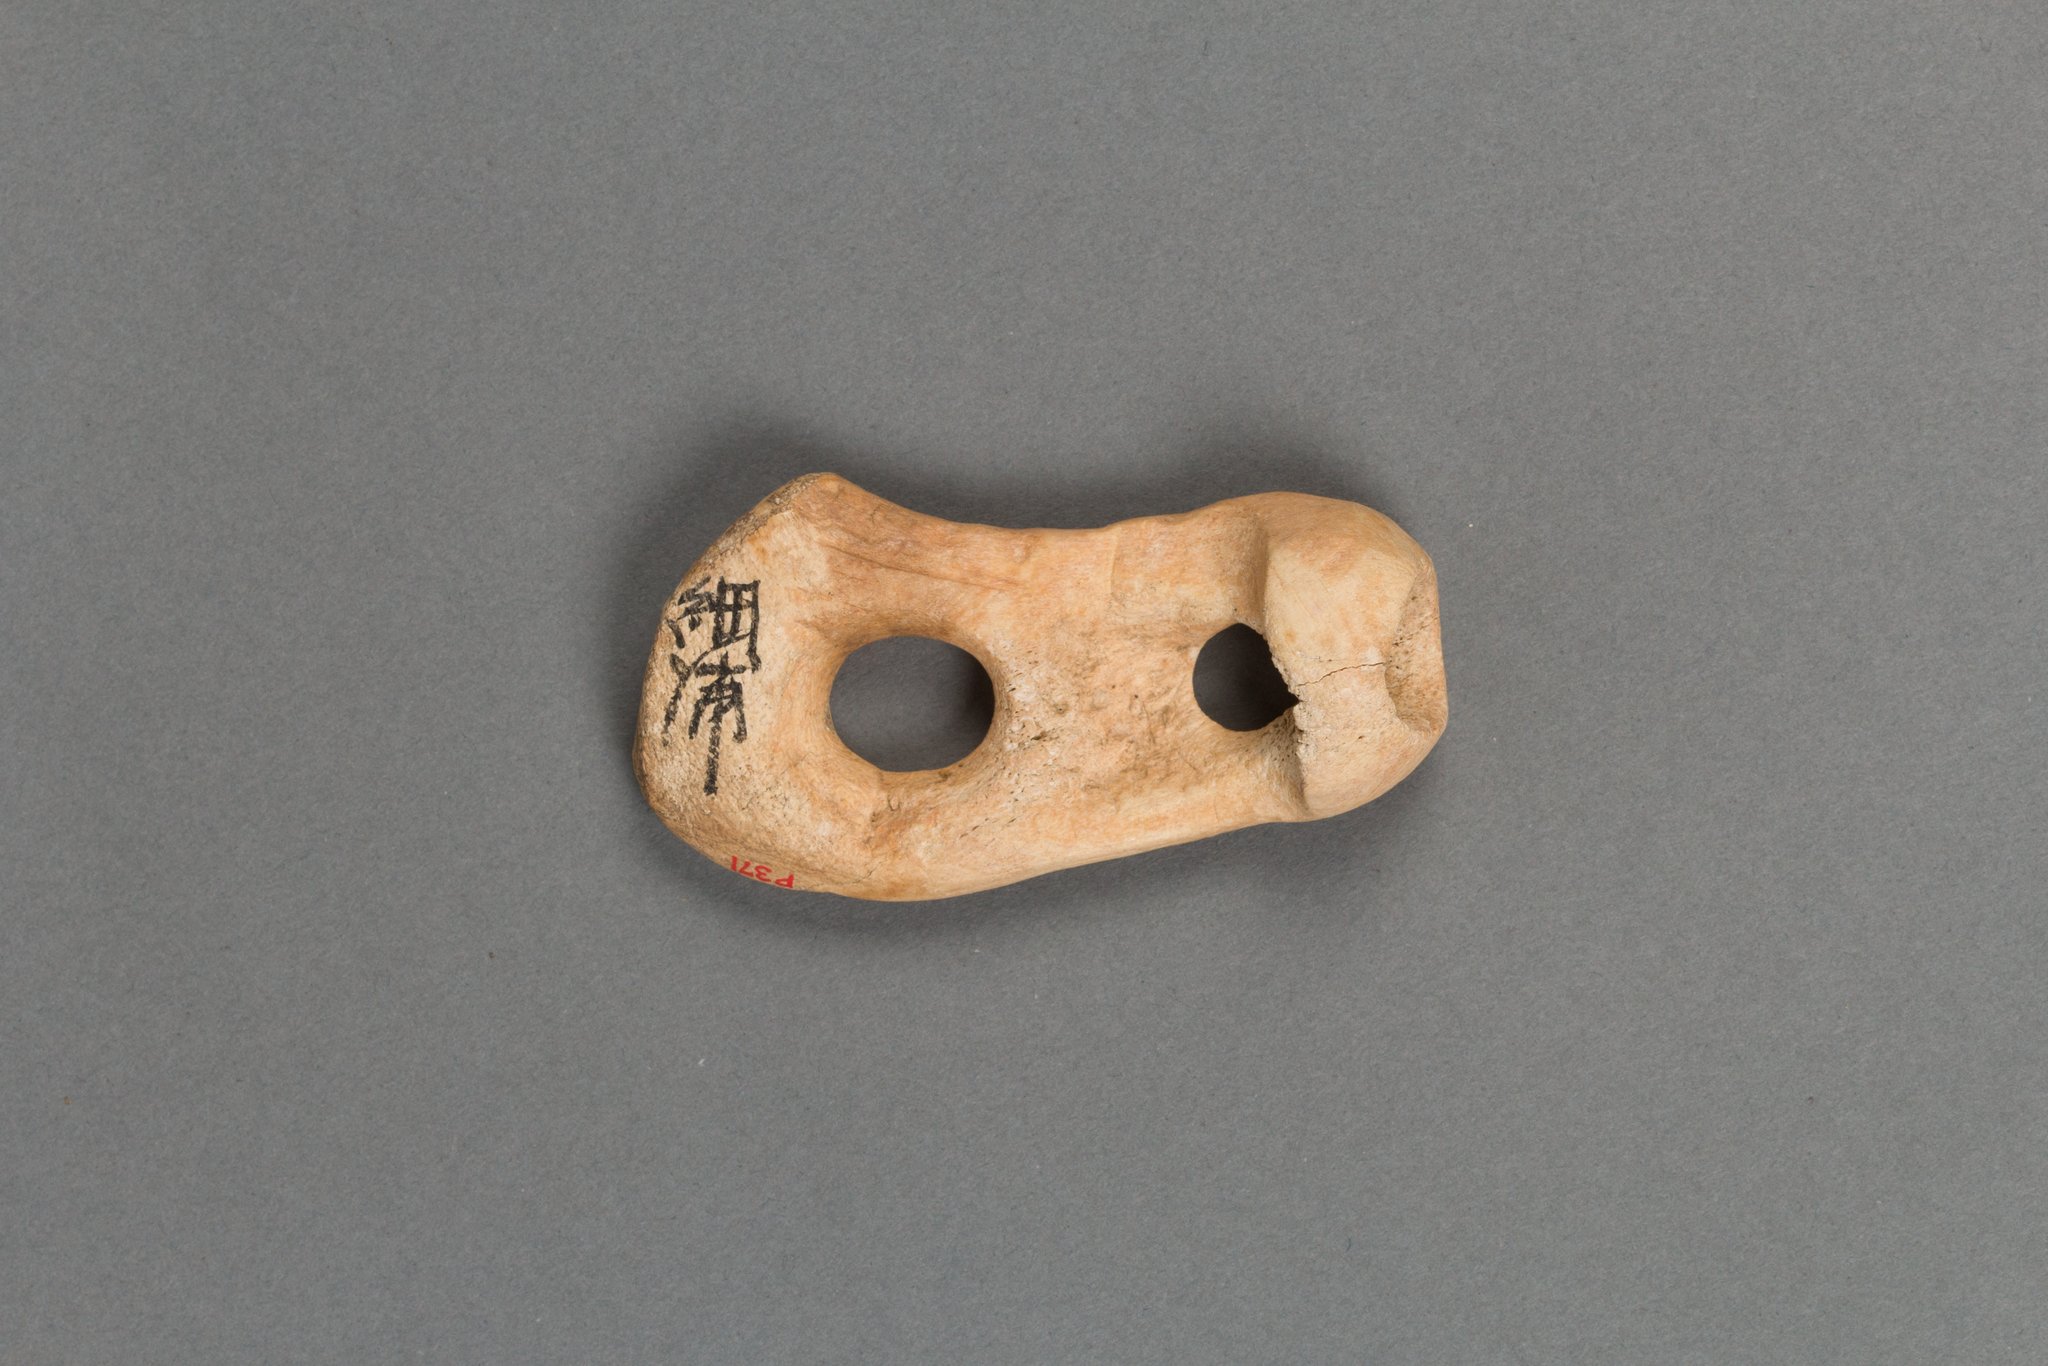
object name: body ornament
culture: japanese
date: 1200-200 BCE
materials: bone